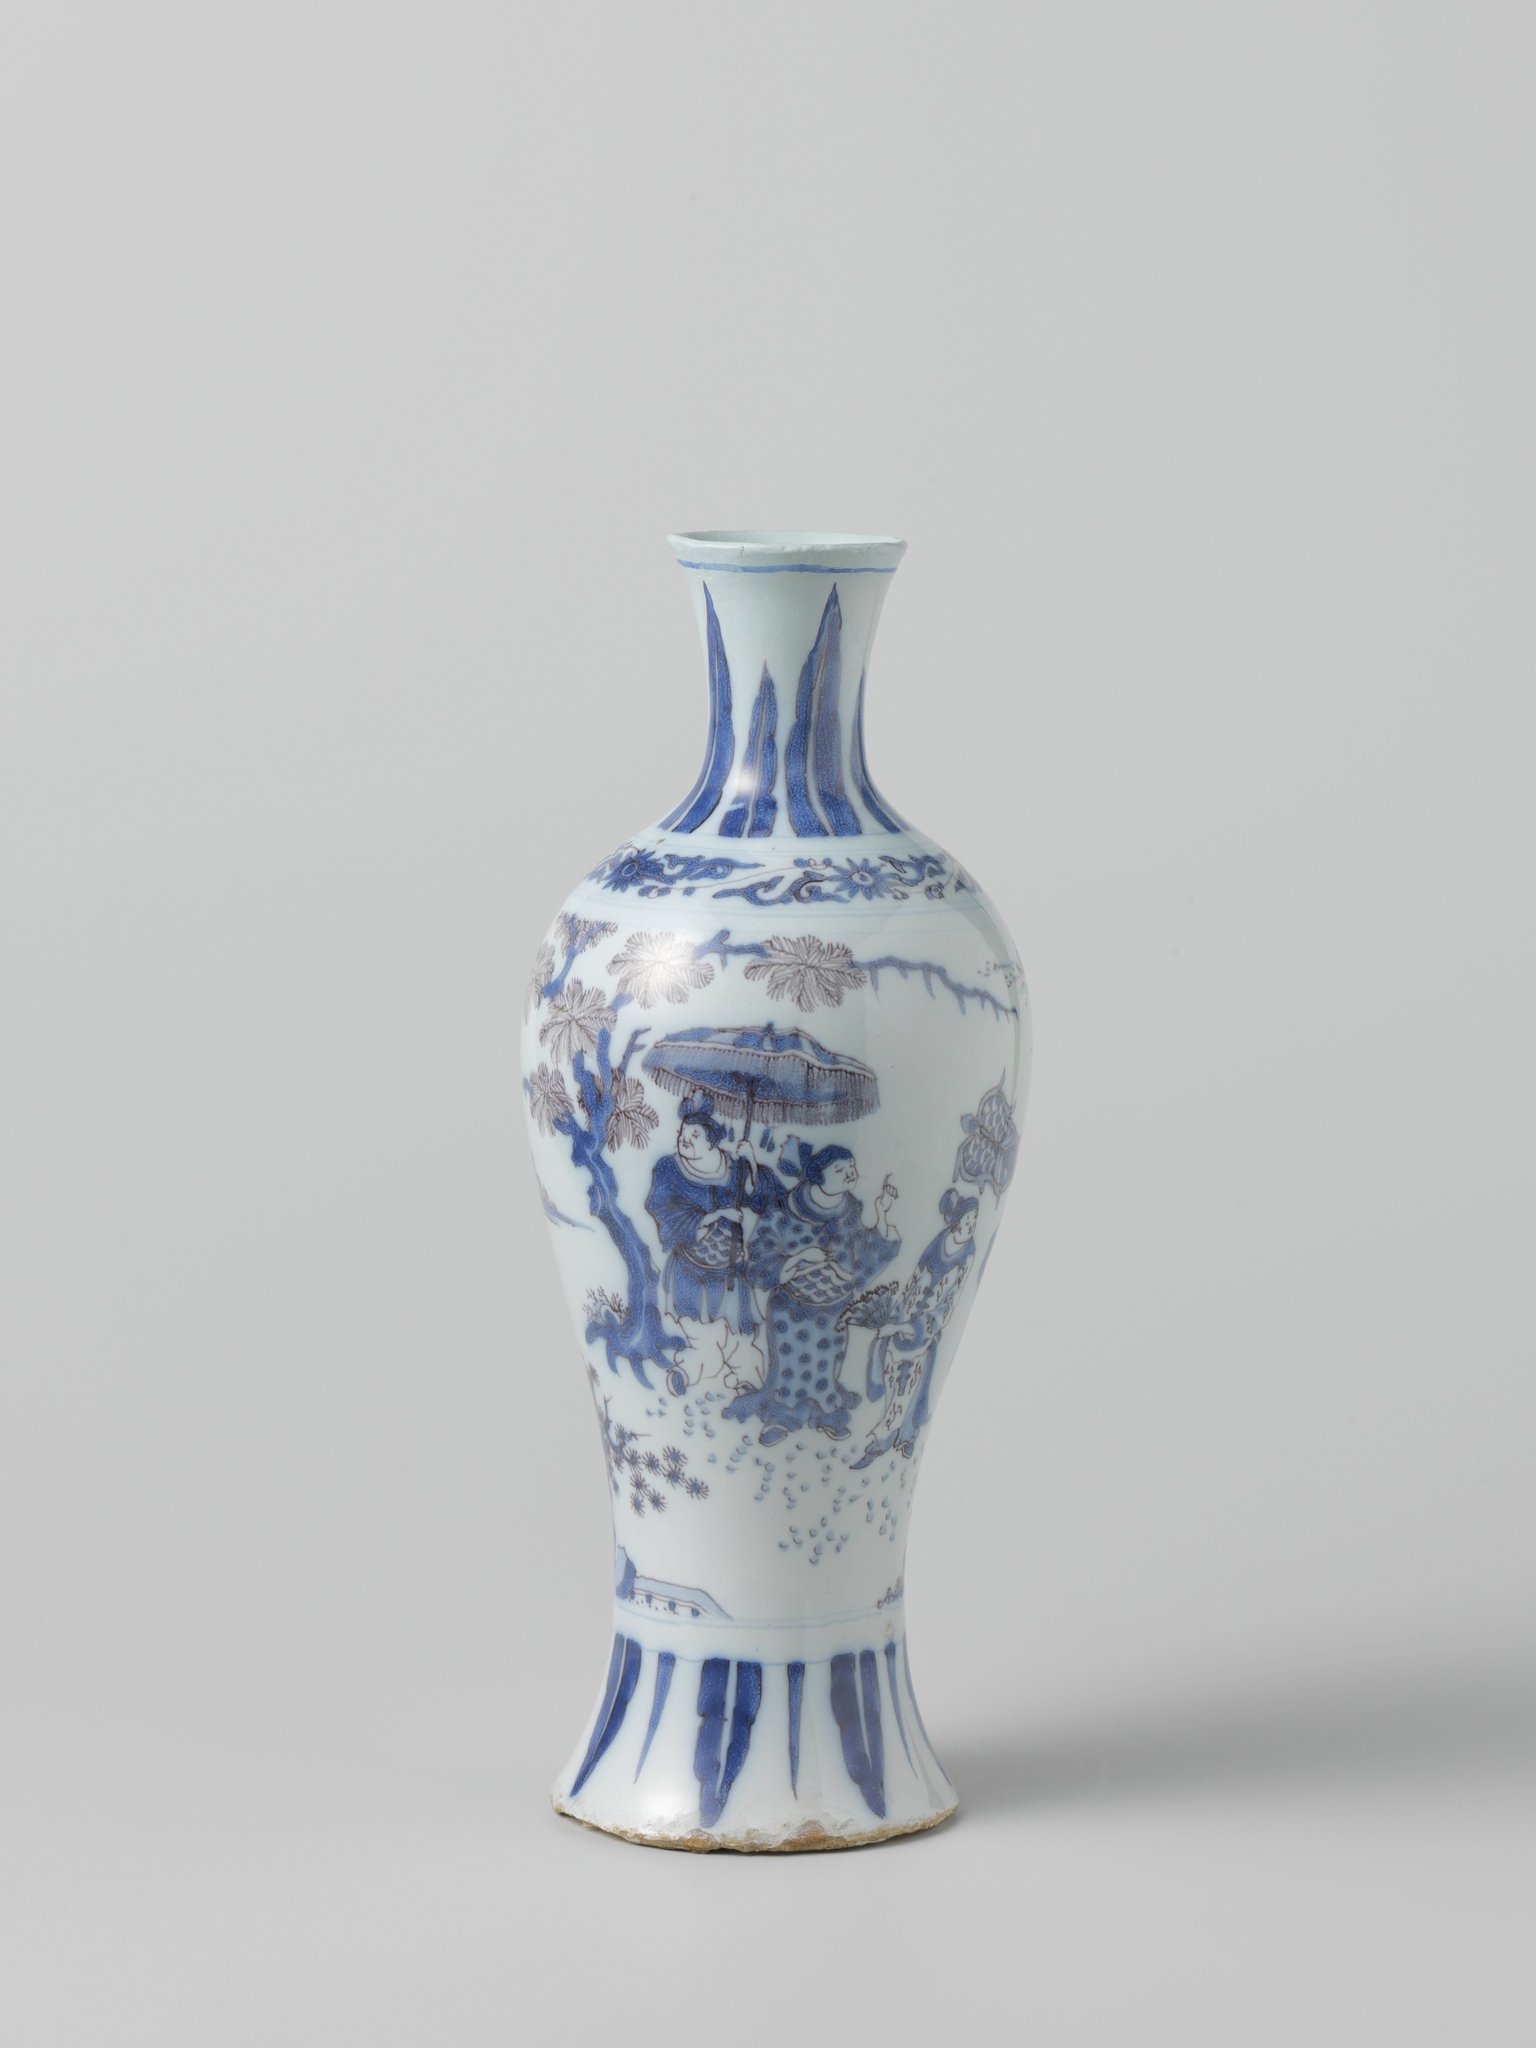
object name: vase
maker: Anonymous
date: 1660-1685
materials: faience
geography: delft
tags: chinese (+ other cultural aspects)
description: Vaas van faience met een decoratie naar het Chinese porselein in de overgangsperiode